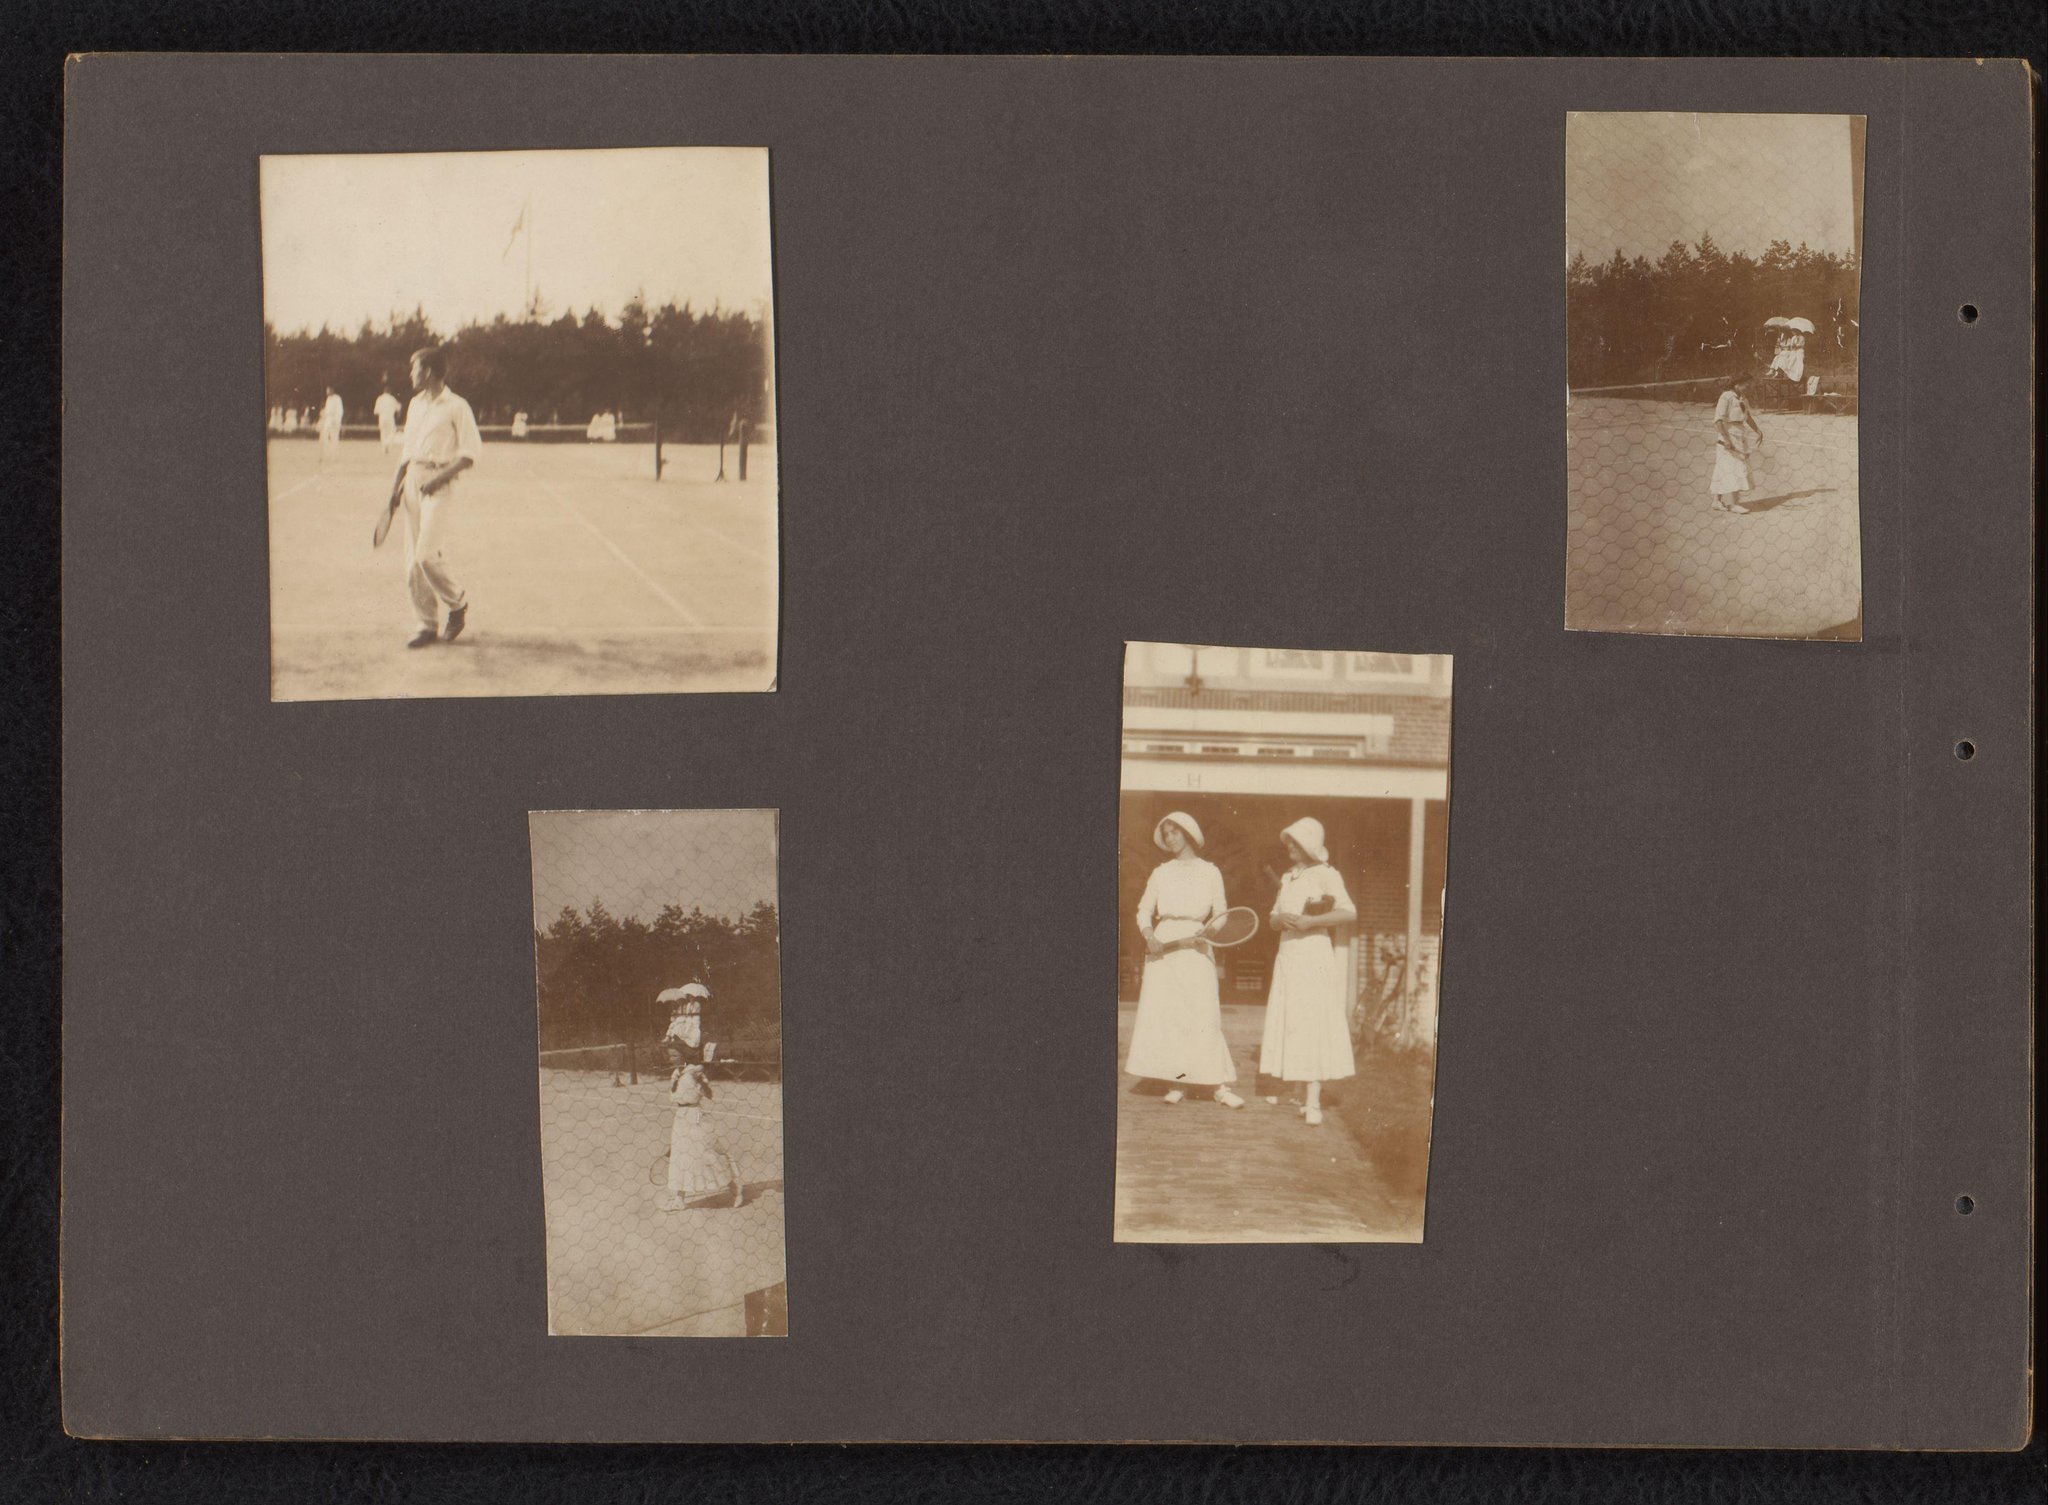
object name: album leaf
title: Tenniswedstrijd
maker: carolina frederika onnen (lien/loen)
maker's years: 1896-1983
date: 1911-1912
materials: paper, cardboard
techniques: gelatin silver print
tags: tennis, lawn-tennis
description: Deze foto's zijn onderdeel van een album.